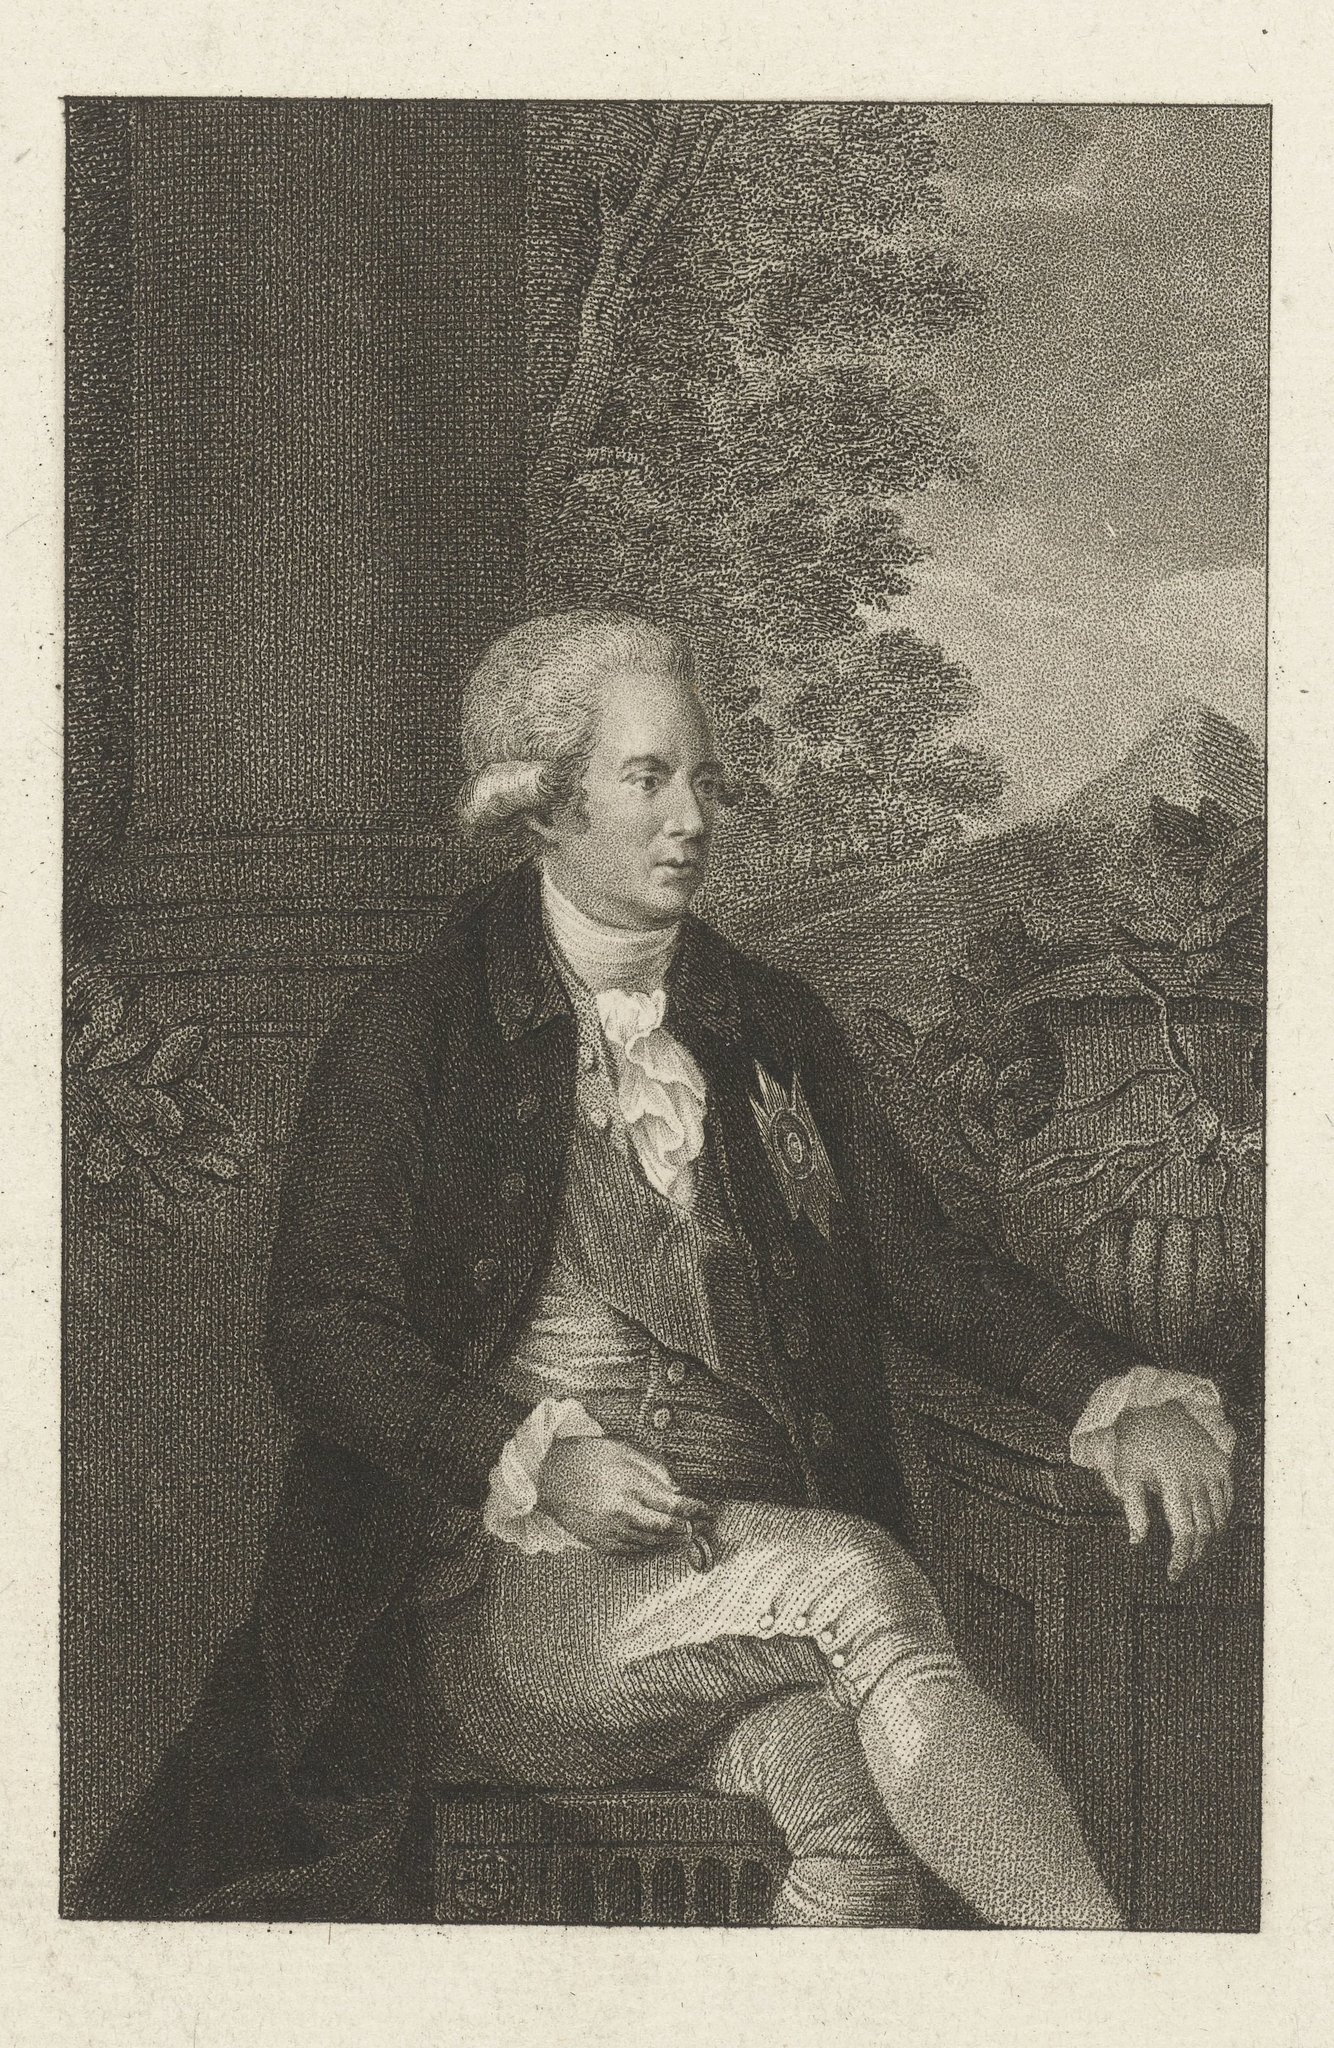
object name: print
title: Portret van George Macartney 1st Earl Macartney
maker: lambertus antonius claessens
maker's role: draughtsman, print maker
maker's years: 1763-1834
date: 1792-1808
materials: paper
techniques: engraving, etching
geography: amsterdam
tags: staatsman, george macartney (1e graaf van macartney)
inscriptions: collector's mark: Lugt 2228